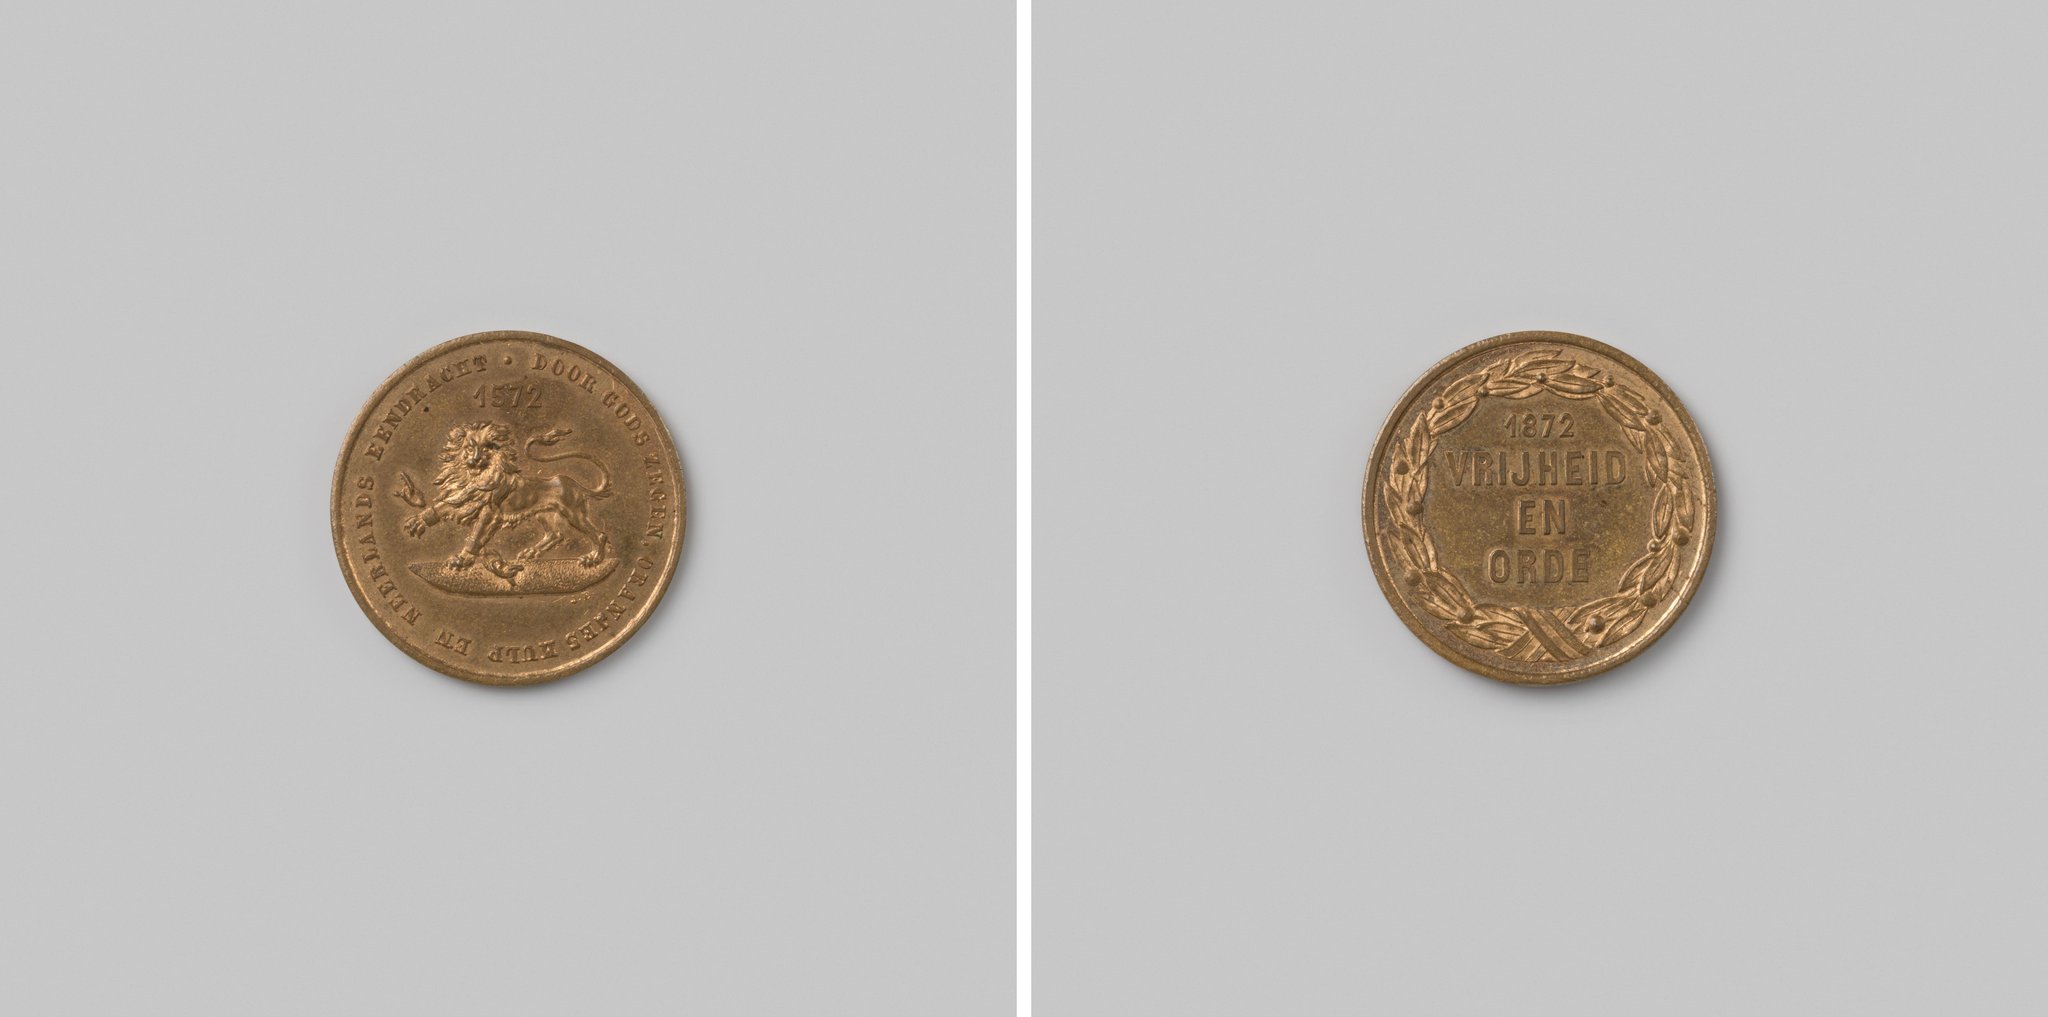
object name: history medal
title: Derde eeuwfeest van de inname van Den Briel, penning uitgegeven door de feestcommissie van Amsterdam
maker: jacob samuel cohen elion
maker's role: draughtsman, painter, print maker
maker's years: 1840-1893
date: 1872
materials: copper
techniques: striking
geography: amsterdam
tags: netherlands, brielle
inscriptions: circumscription: ‘DOOR GODS ZEGEN, ORANJES HULP EN NEERLANDS EENDRACHT’, date: ‘1572’, inscription: ‘1872 VRIJHEID EN ORDE’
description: Koperen penning op de herdenking van het feit dat in 1872 de opstand tegen Spanje driehonderd jaar geleden haar eerste successen bracht. Voorzijde: een naar links gaande leeuw verbreekt de boeien om zijn voorpoten. Boven hem jaartal en omschrift. Keerzijde: binnen een lauwerkrans opschrift.